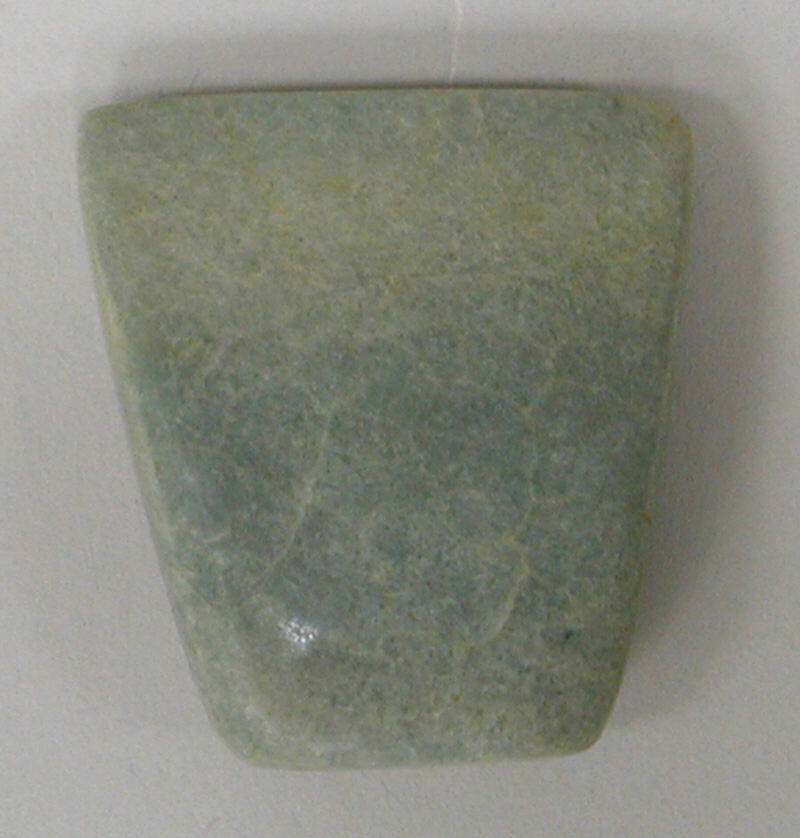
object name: chisel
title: Stone Chisel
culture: mexican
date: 1501-1600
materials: stone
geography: mexico